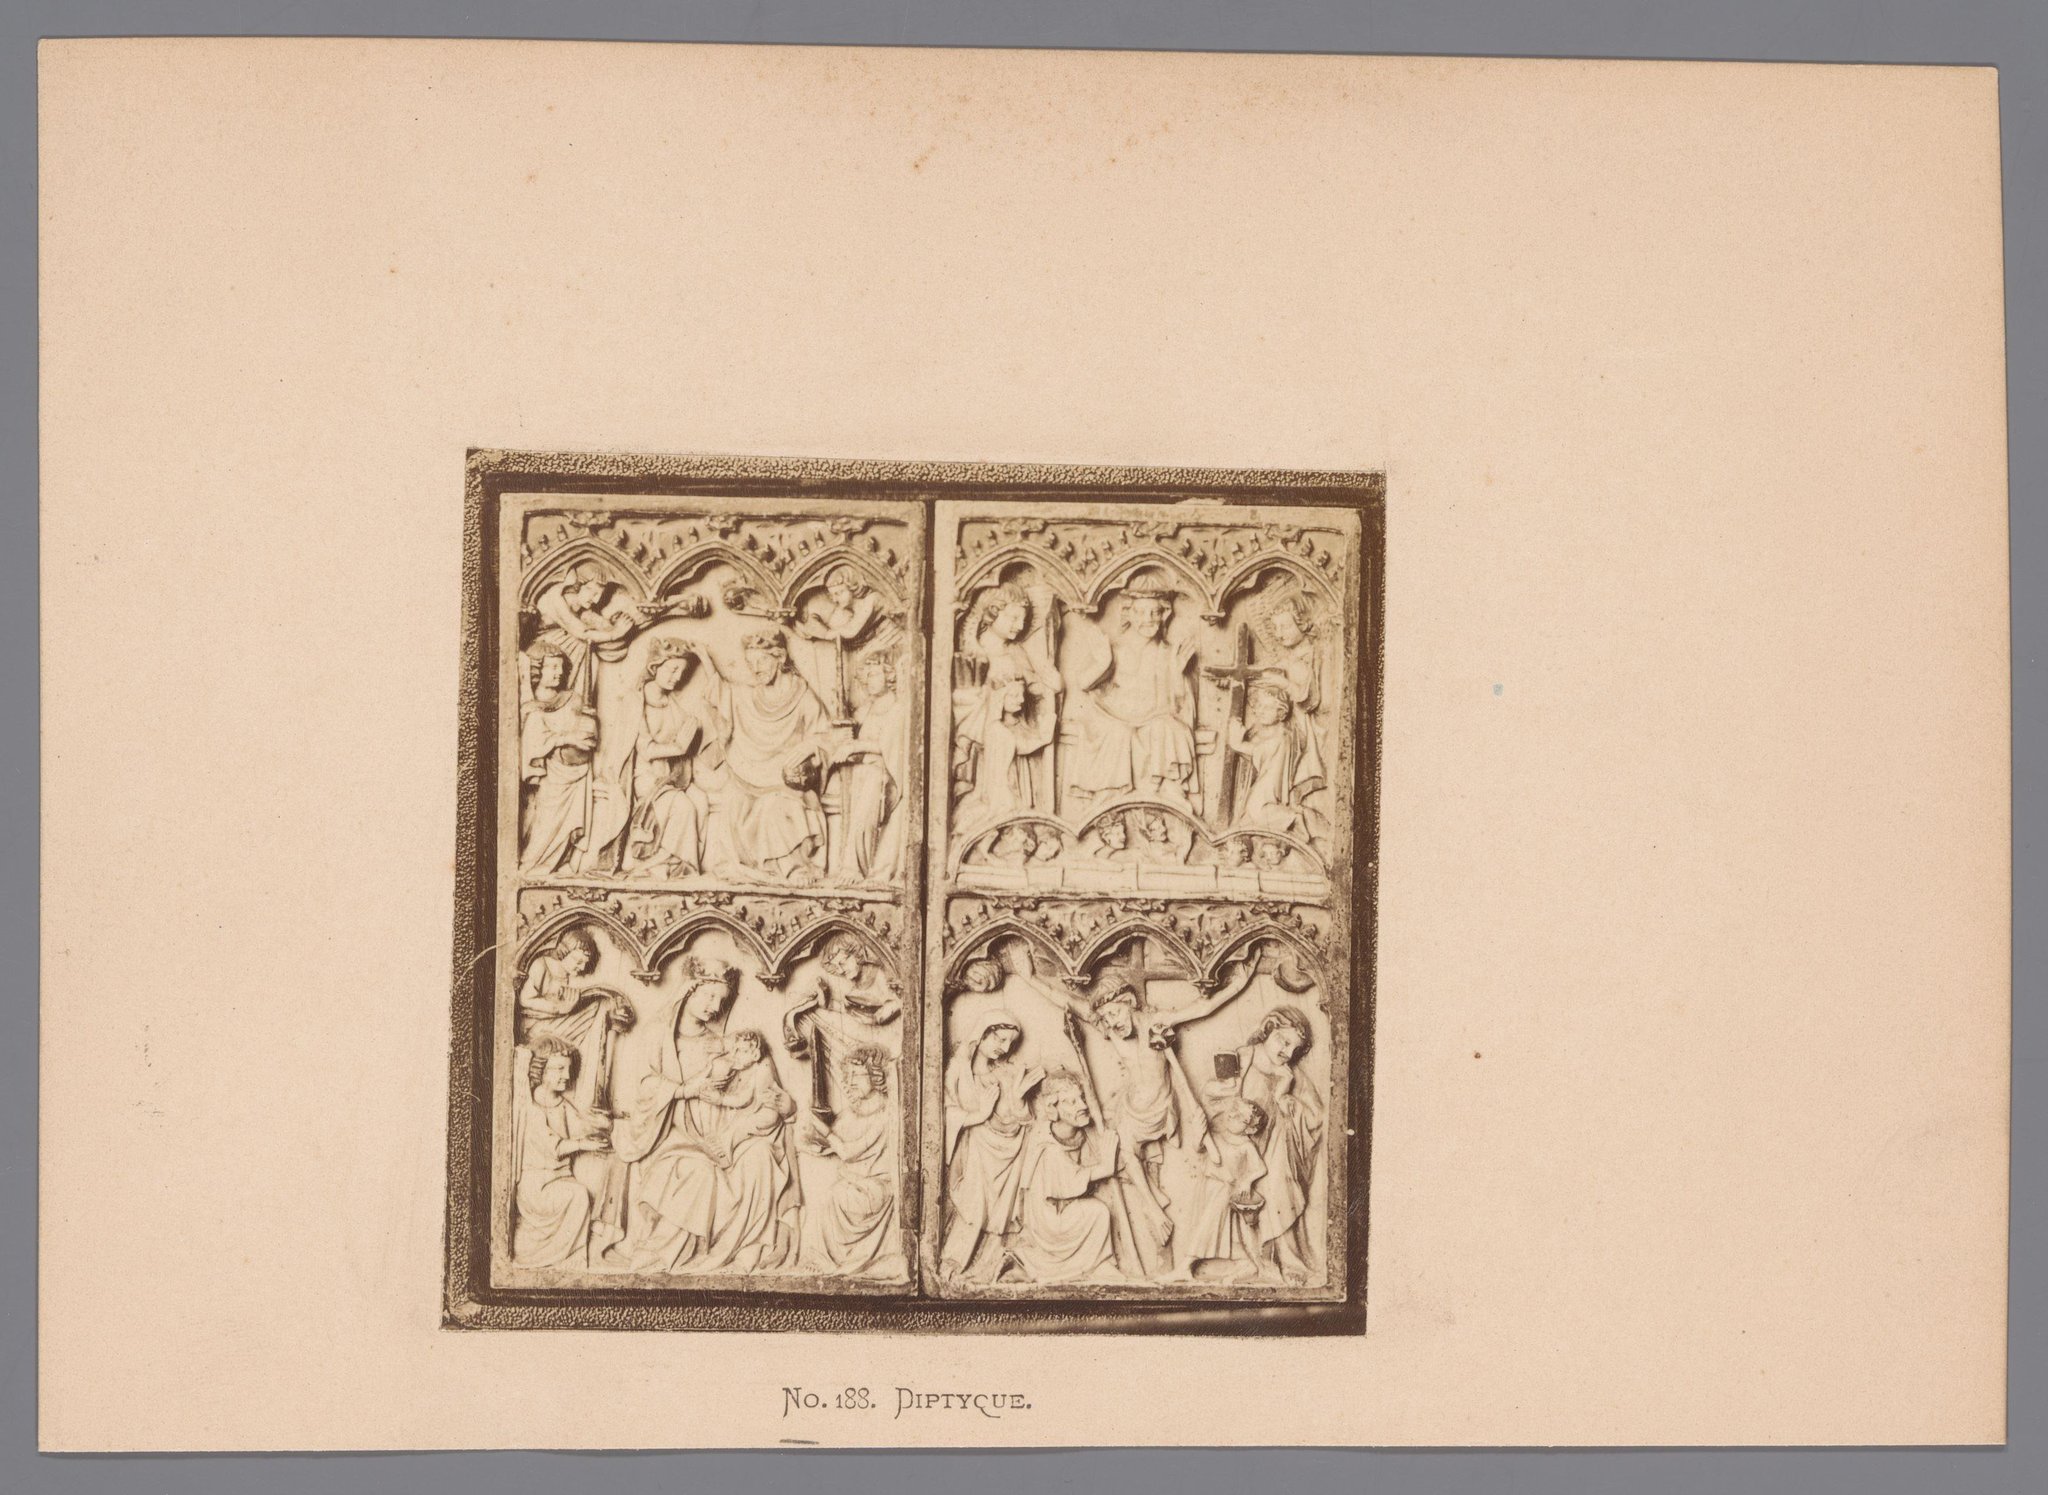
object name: photograph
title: Diptyque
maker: Anonymous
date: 1870-1890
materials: cardboard, paper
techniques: albumen print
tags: piece of sculpture, reproduction of a piece of sculpture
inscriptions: collector's mark: Lugt 2228a, number: ‘No. 188.’